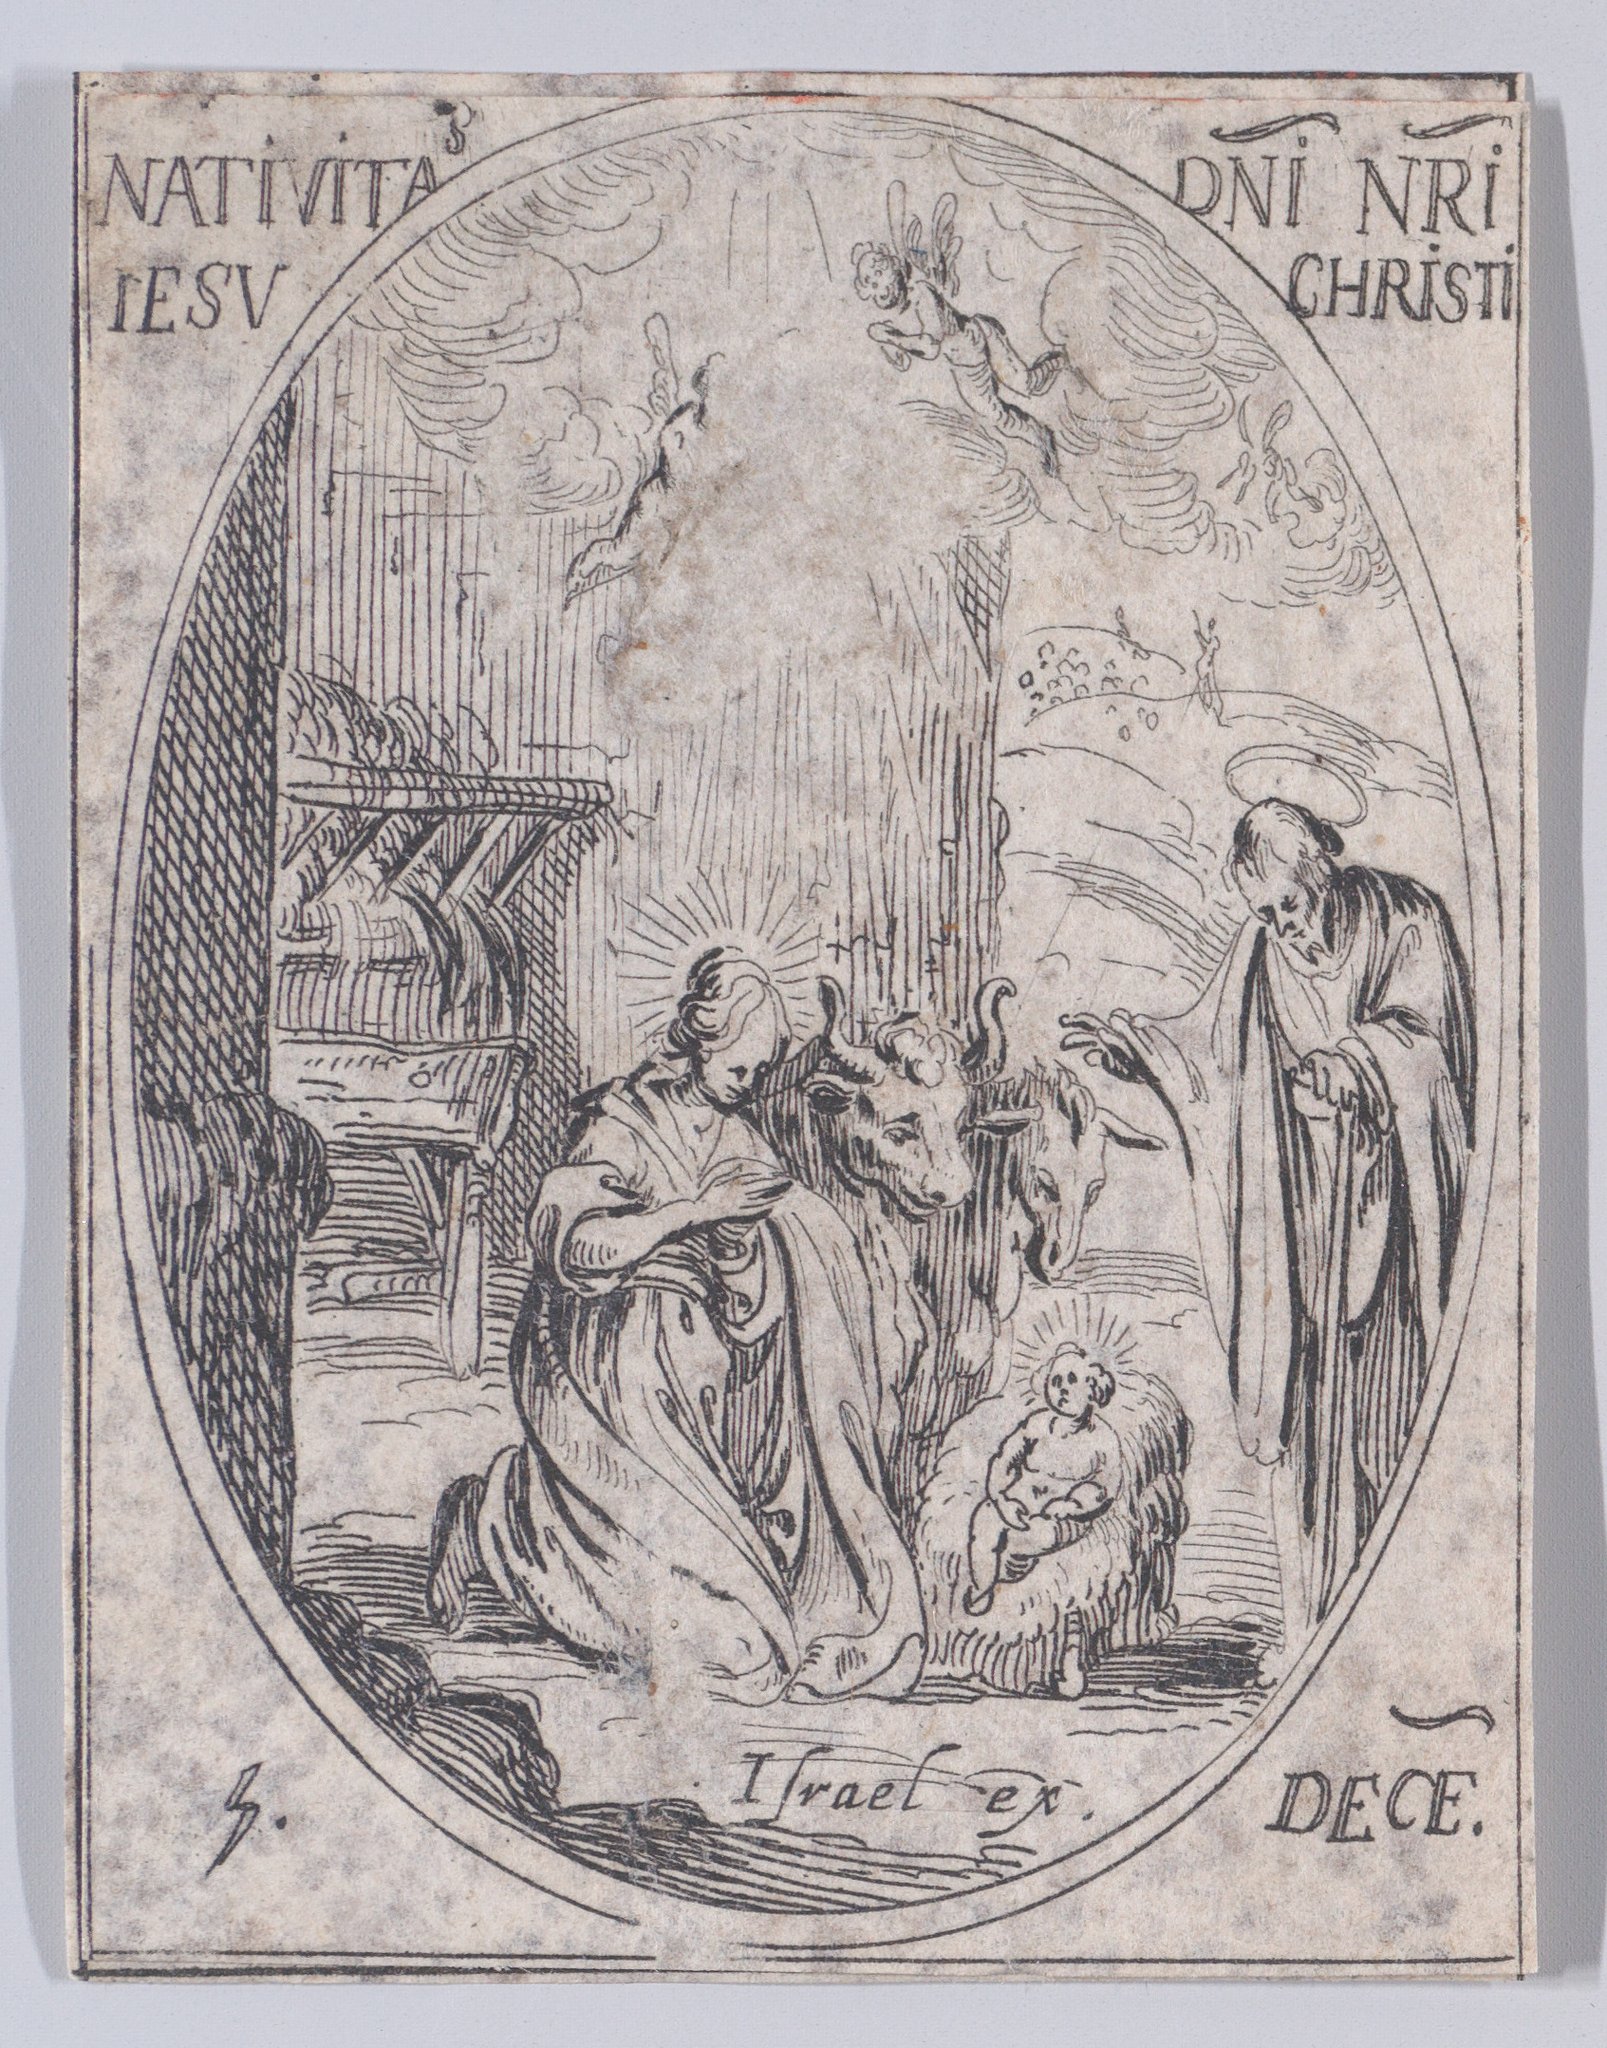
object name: print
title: Nativité de N.-Segneur Jésus-Christ (The Nativity), December 25th, from "Les Images De Tous Les Saincts et Saintes de L'Année" (Images of All of the Saints and Religious Events of the Year)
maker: jacques callot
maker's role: artist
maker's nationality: french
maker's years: 1592-1635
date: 1636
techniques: etching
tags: virgin mary,jesus,nativity,joseph